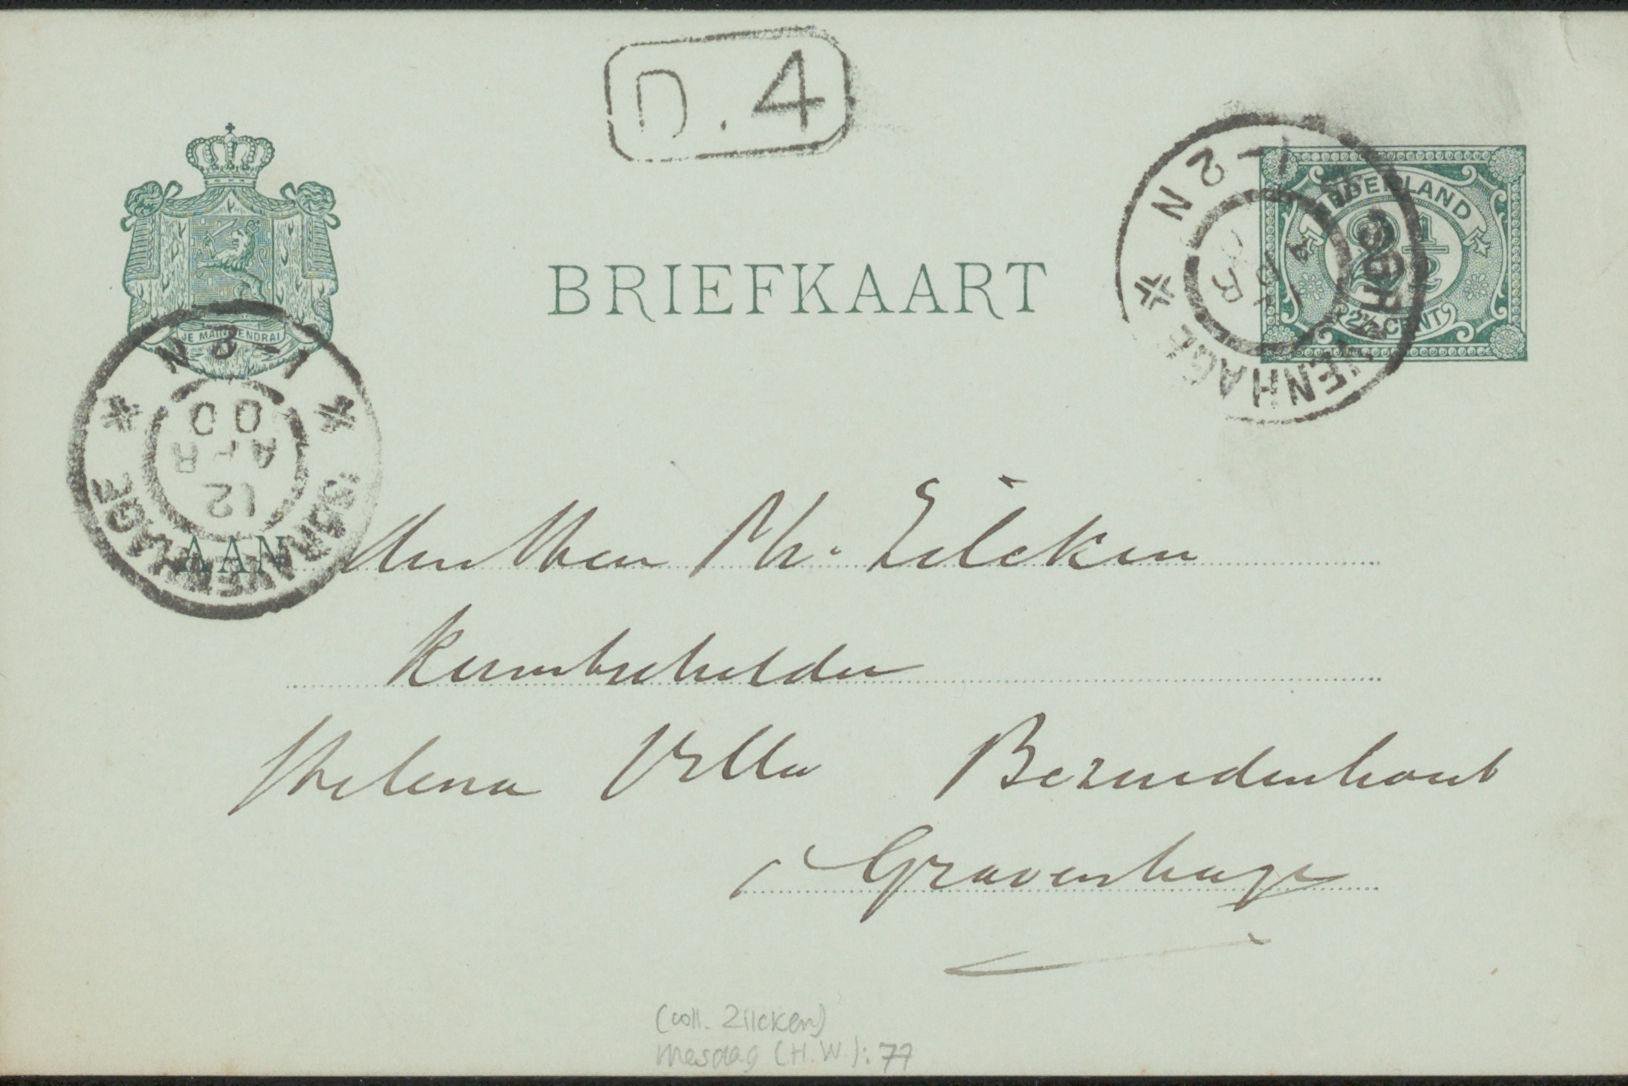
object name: postcard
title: Briefkaart aan Philip Zilcken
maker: hendrik willem mesdag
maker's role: draughtsman, painter, print maker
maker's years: 1831-1915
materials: cardboard, ink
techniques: pen, writing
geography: the hague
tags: philip zilcken, paris